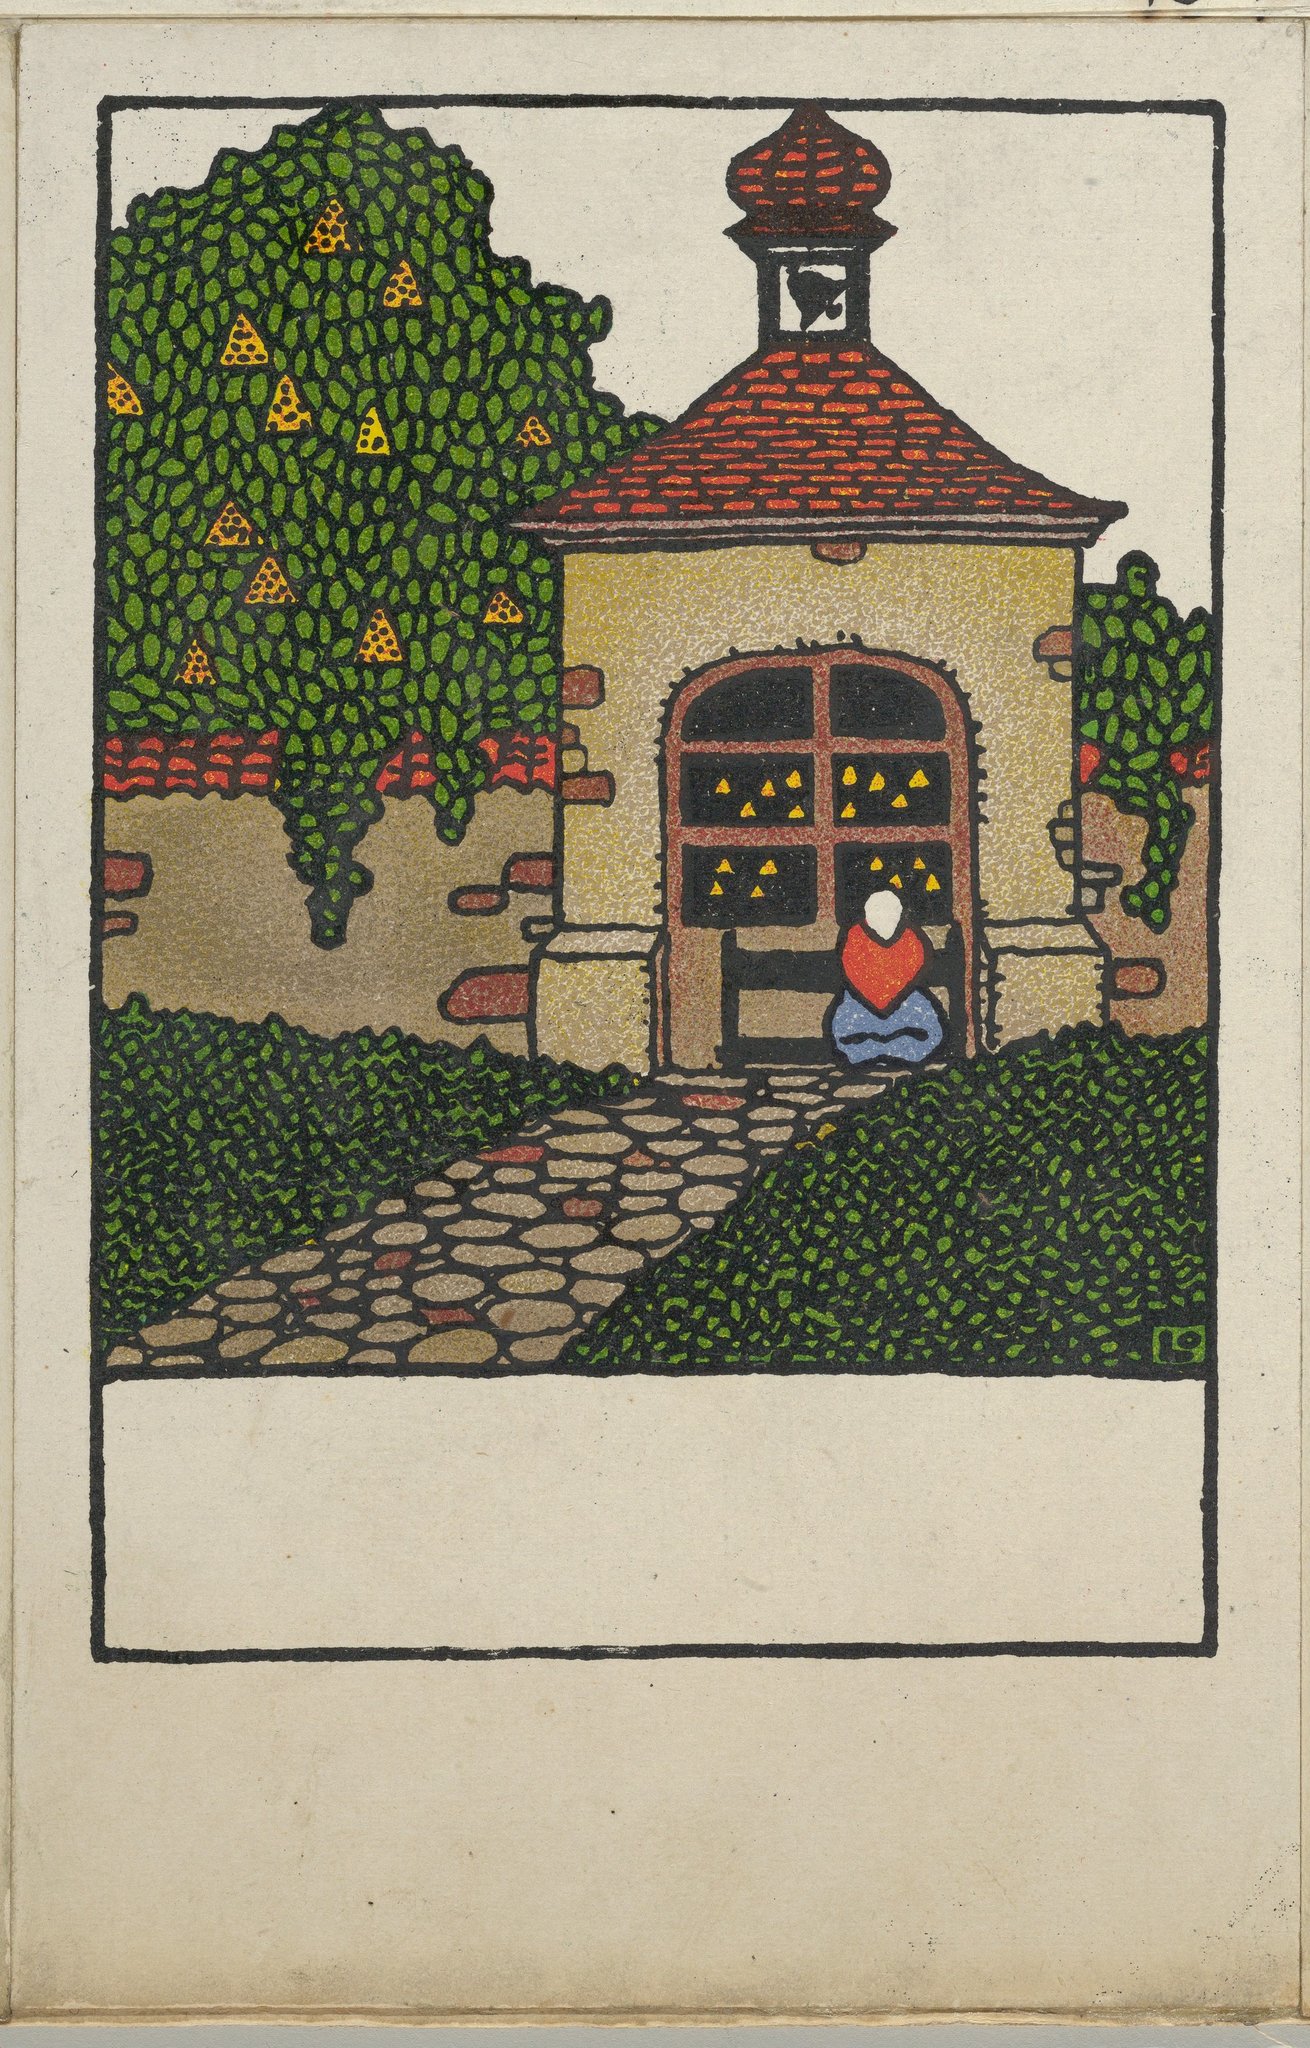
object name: print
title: Easter Card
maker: otto friedr. carl lendecke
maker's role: artist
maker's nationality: austrian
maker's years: 1886-1918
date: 1908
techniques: lithograph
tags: human figures,temples